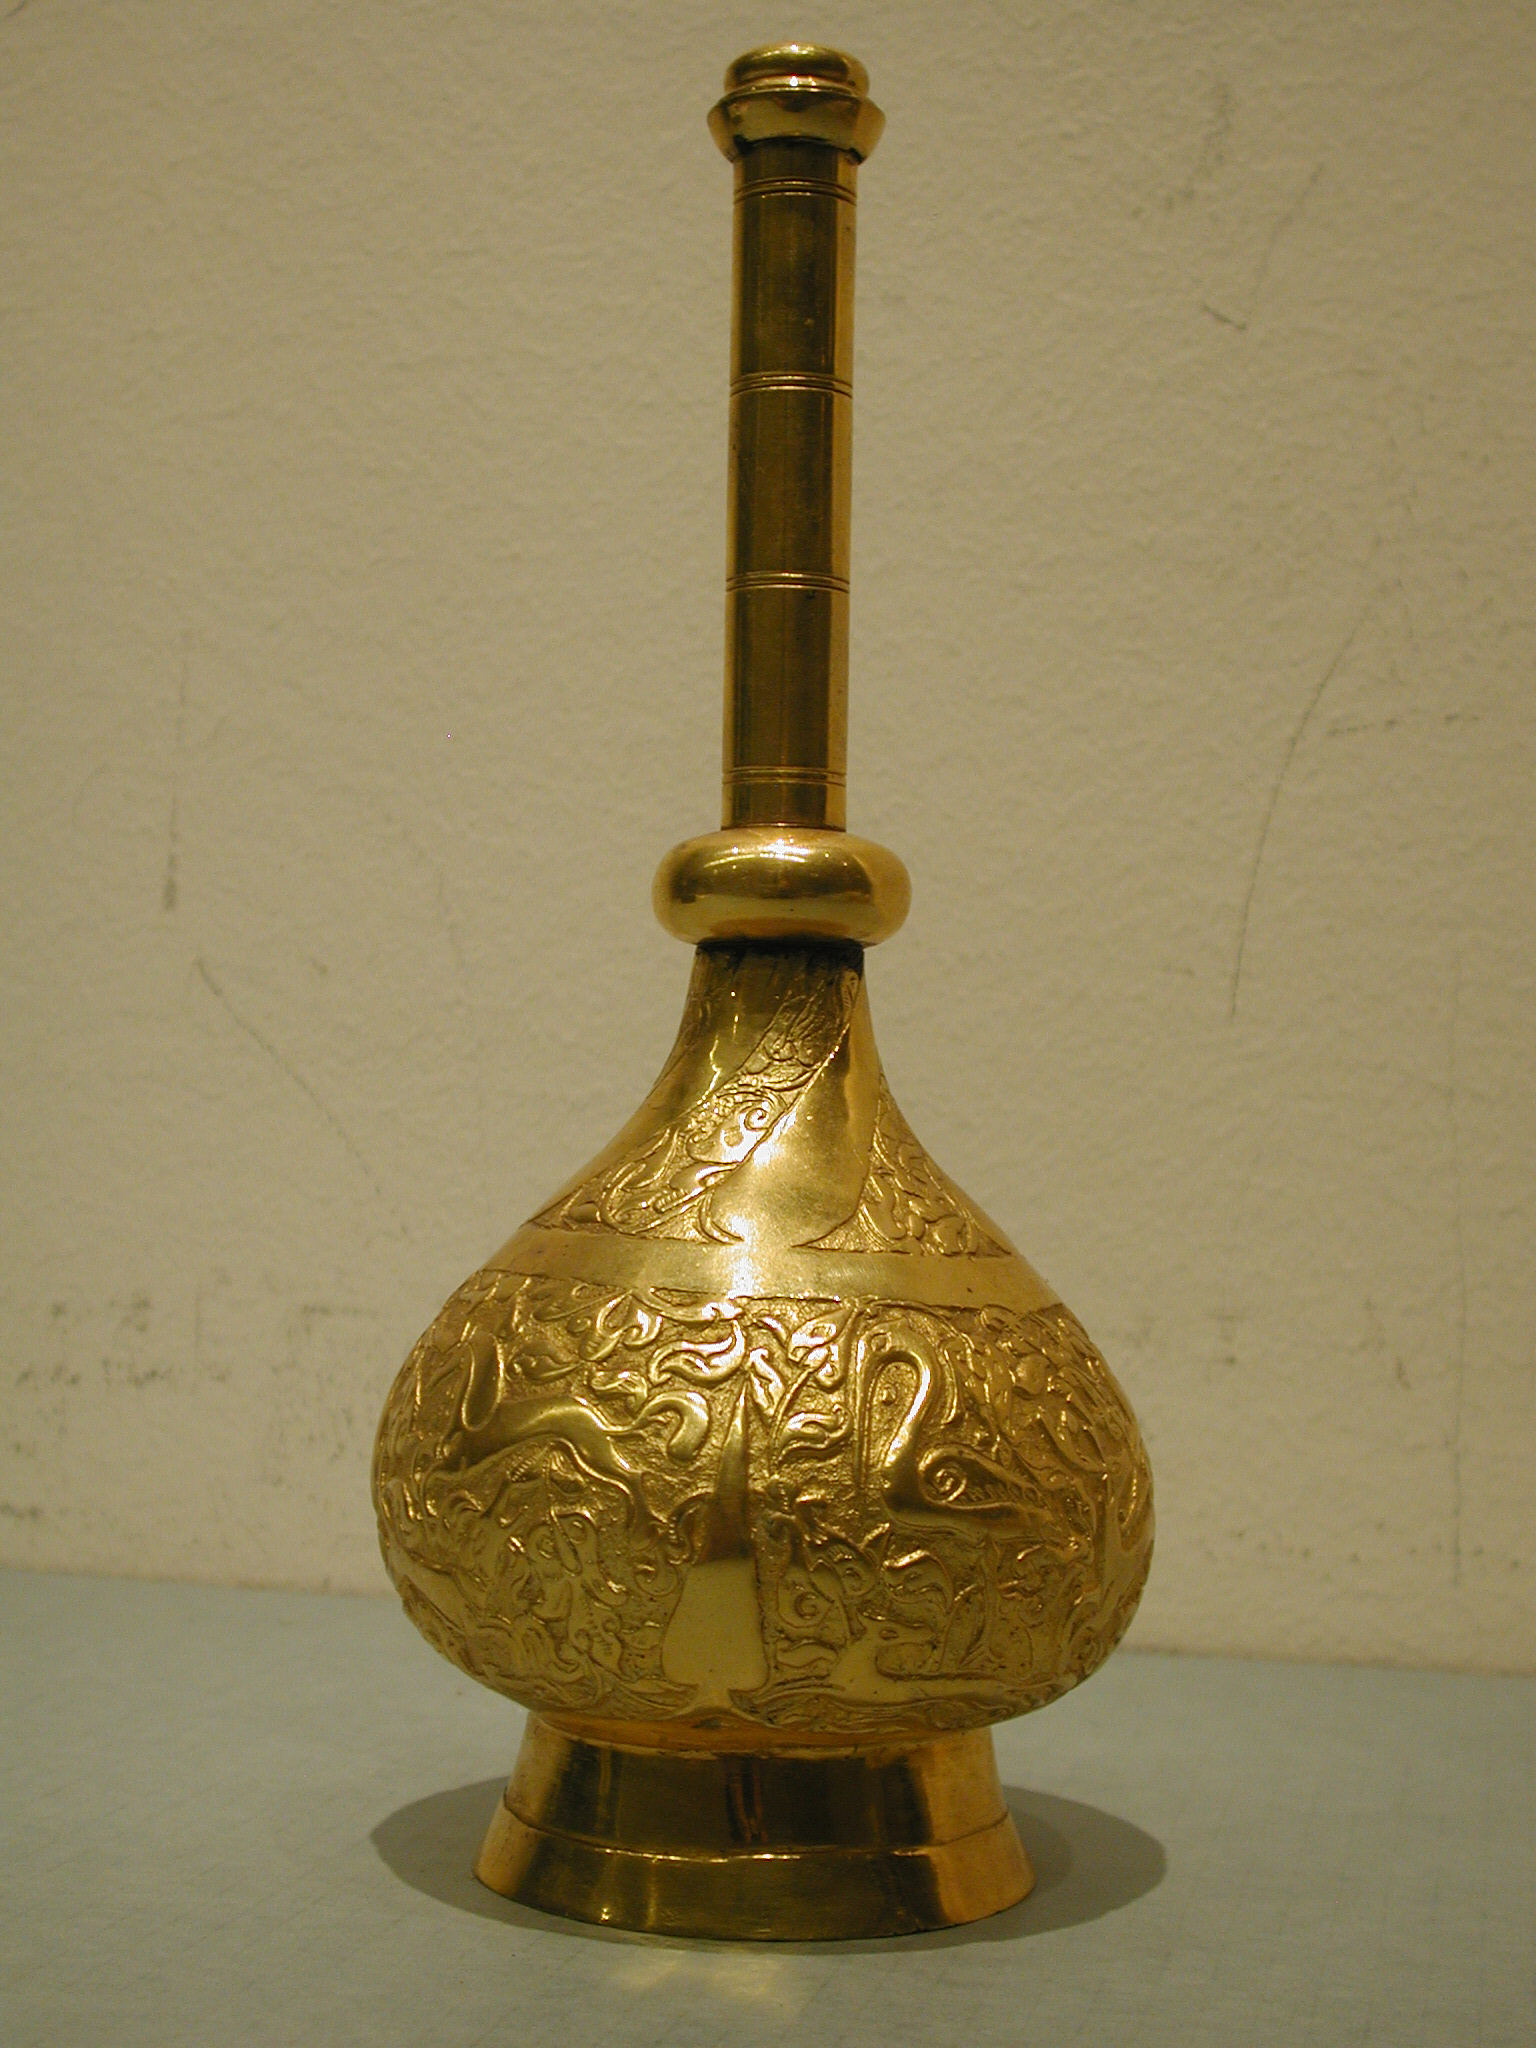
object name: vase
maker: elkington & co.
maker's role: manufacturer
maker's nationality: british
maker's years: 1829-1963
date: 1801-1900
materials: metal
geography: england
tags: animals,birds